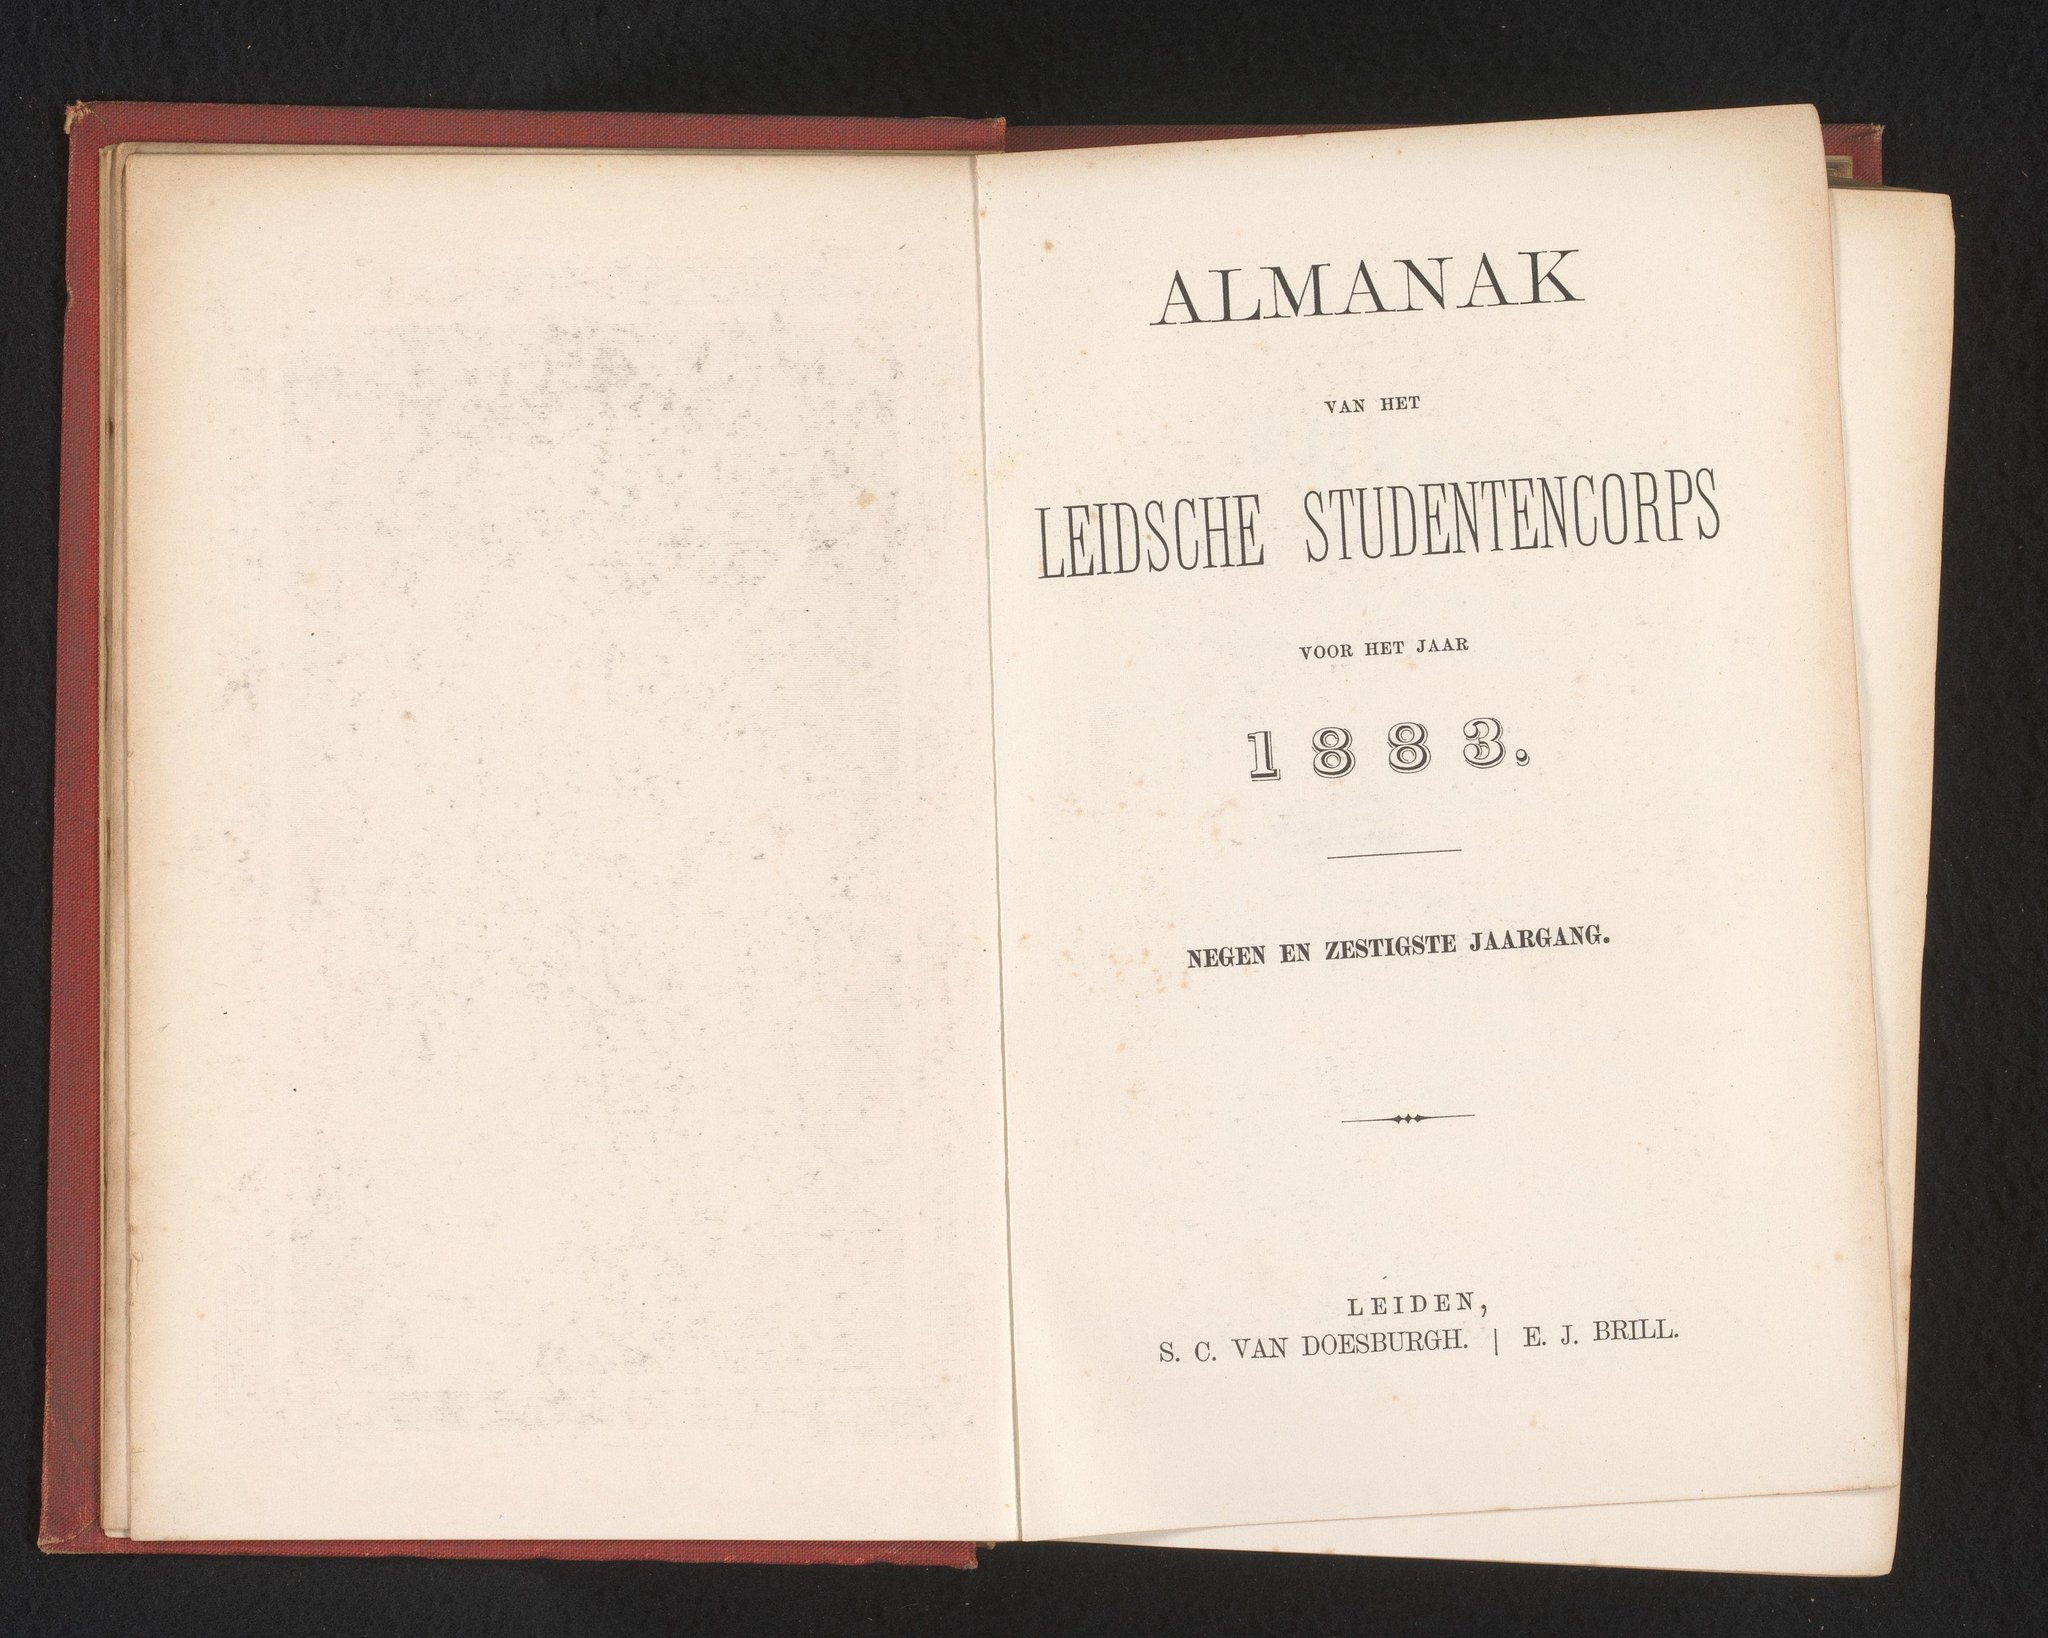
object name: book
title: Almanak van het Leidsche Studentencorps voor het jaar 1883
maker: simon cornelis van doesburgh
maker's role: publisher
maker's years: 1835-1906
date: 1882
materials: paper, cardboard, textile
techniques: engraving, letterpress printing, woodburytype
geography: leiden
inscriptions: inscription: ‘Aan den/ Weled. Hooggeleerden Heer/ Dr. D. Doijer/ aangeboden/ namens de Almanak-redactie/ [...]/ praeses.’